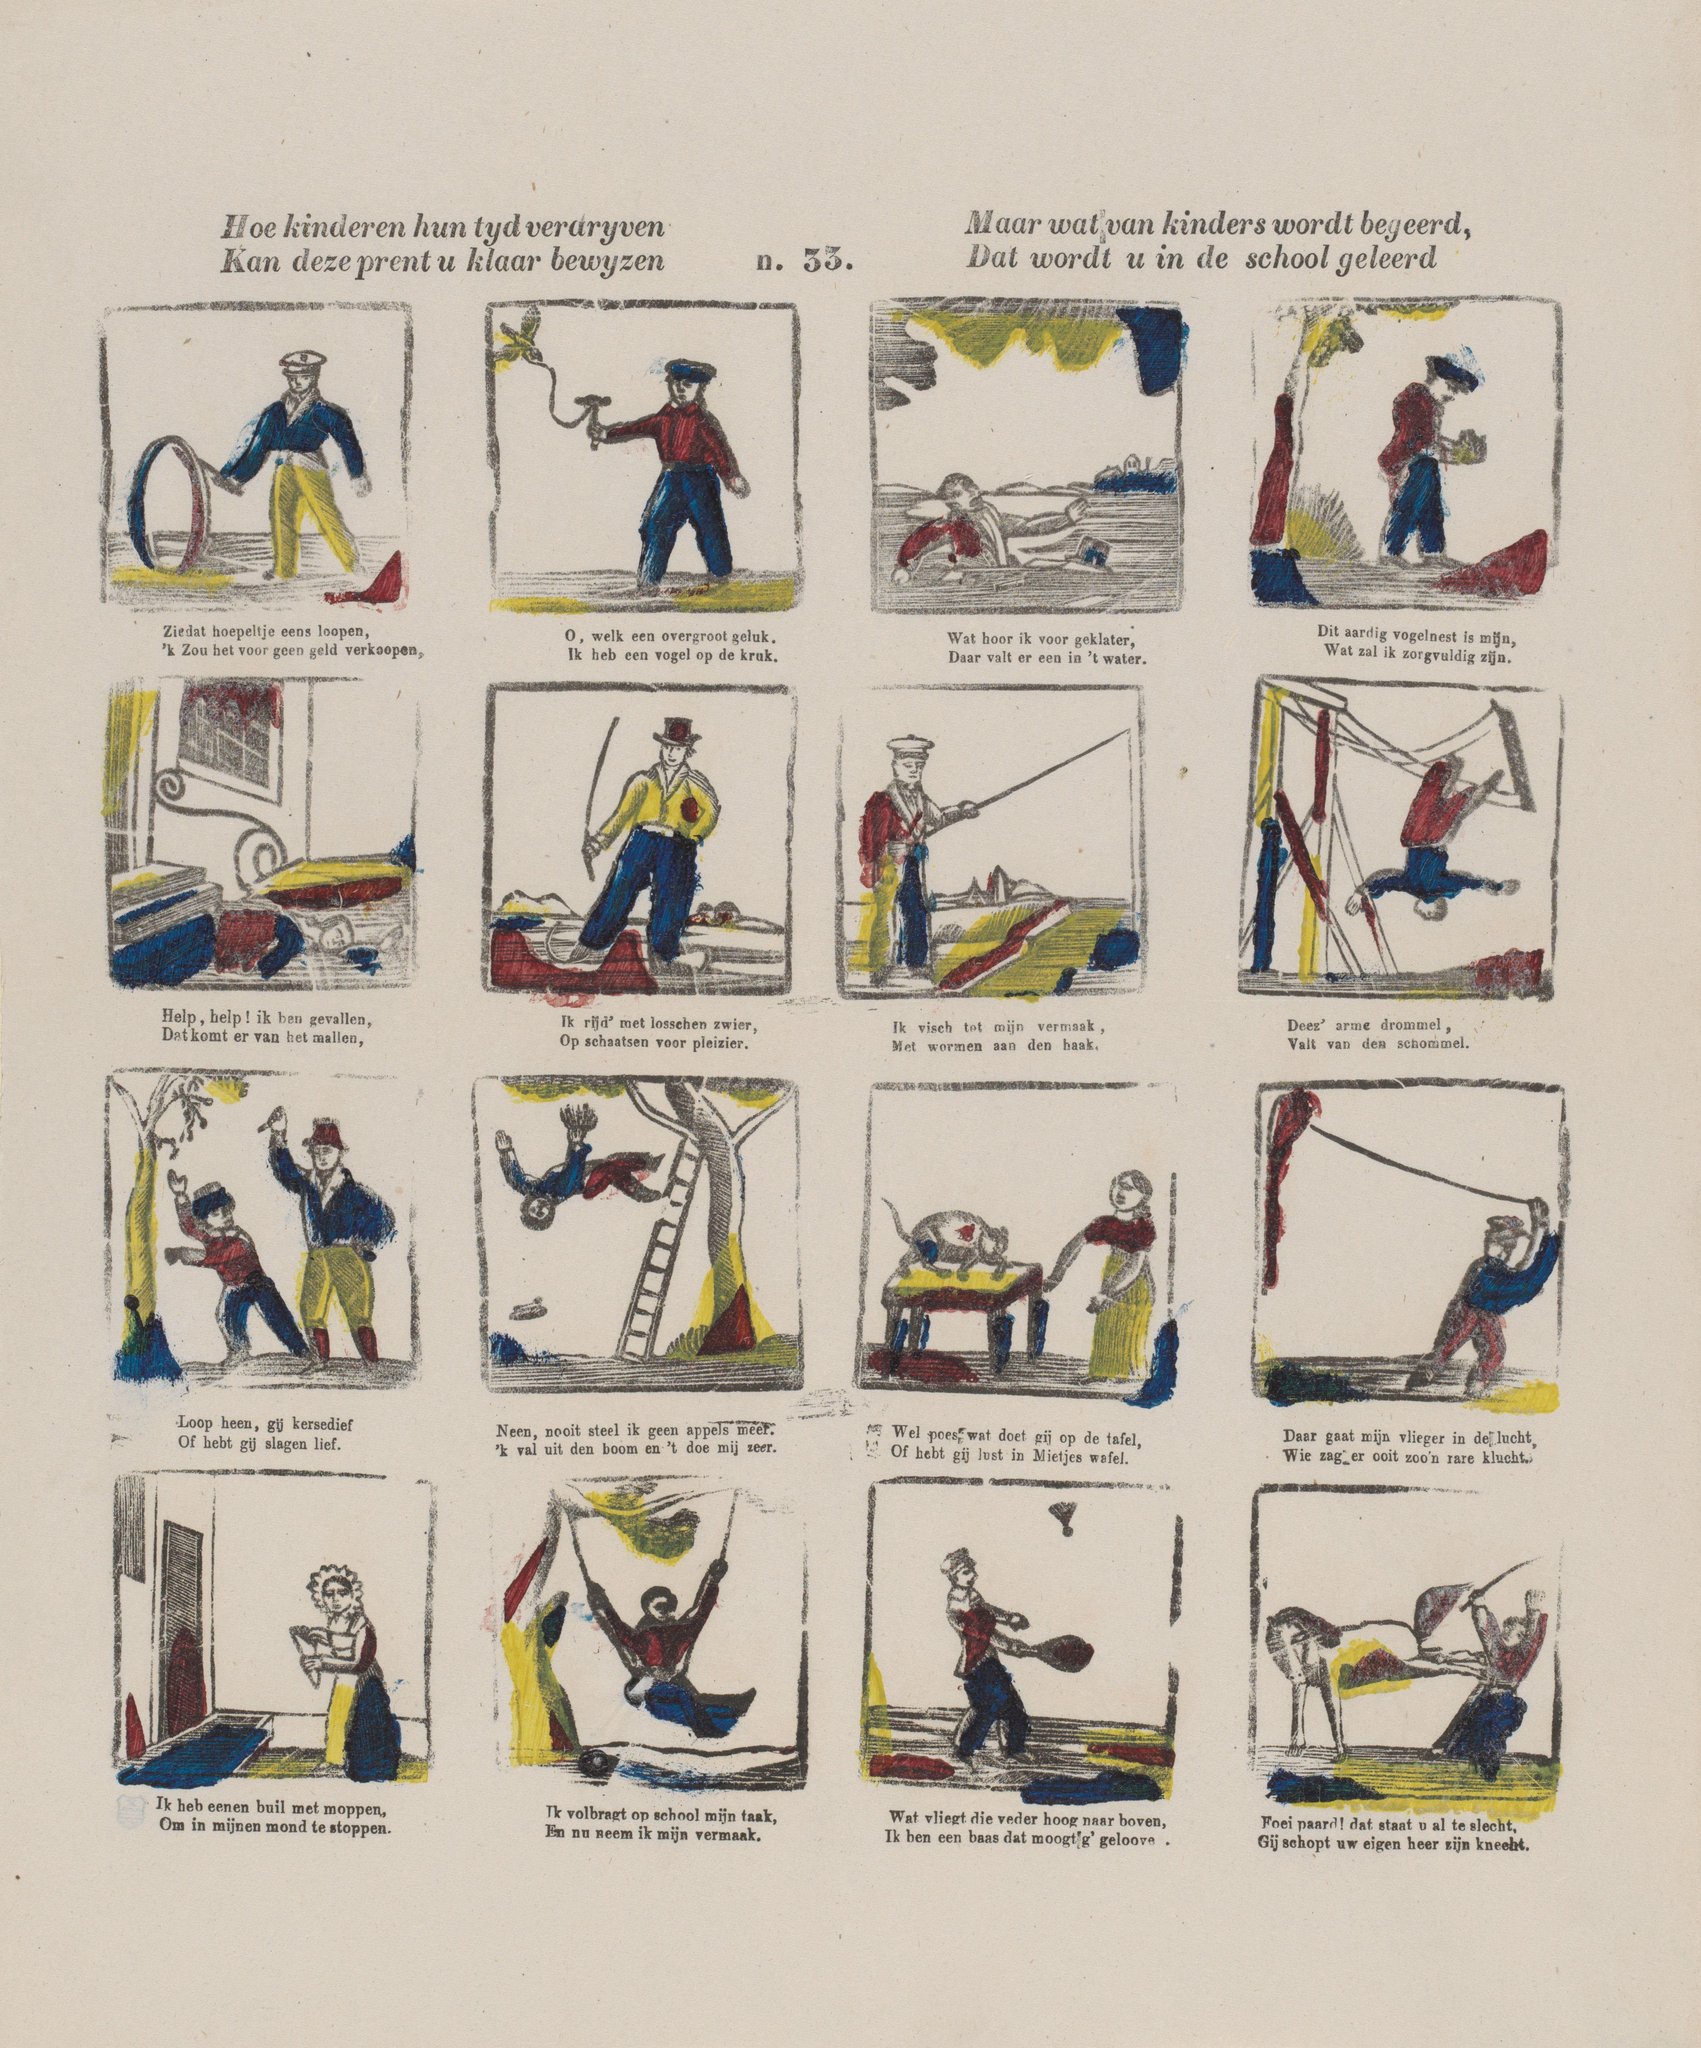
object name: print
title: Hoe kinderen hun tyd verdryven / Kan deze prent u klaar bewyzen / Maar wat van kinders wordt begeerd, / Dat wordt u in de school geleerd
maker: Anonymous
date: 1848-1881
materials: paper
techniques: colour, letterpress printing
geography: netherlands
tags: children's games and plays, (flying a) kite, games using special objects (marbles, top, hoop, etc.)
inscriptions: collector's mark: Lugt 2760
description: Blad met 16 voorstellingen van kinderspelen en bezigheden, zoals hoepelen, vliegeren en schommelen. Onder elke afbeelding een tweeregelig vers. Genummerd midden boven: n. 33.